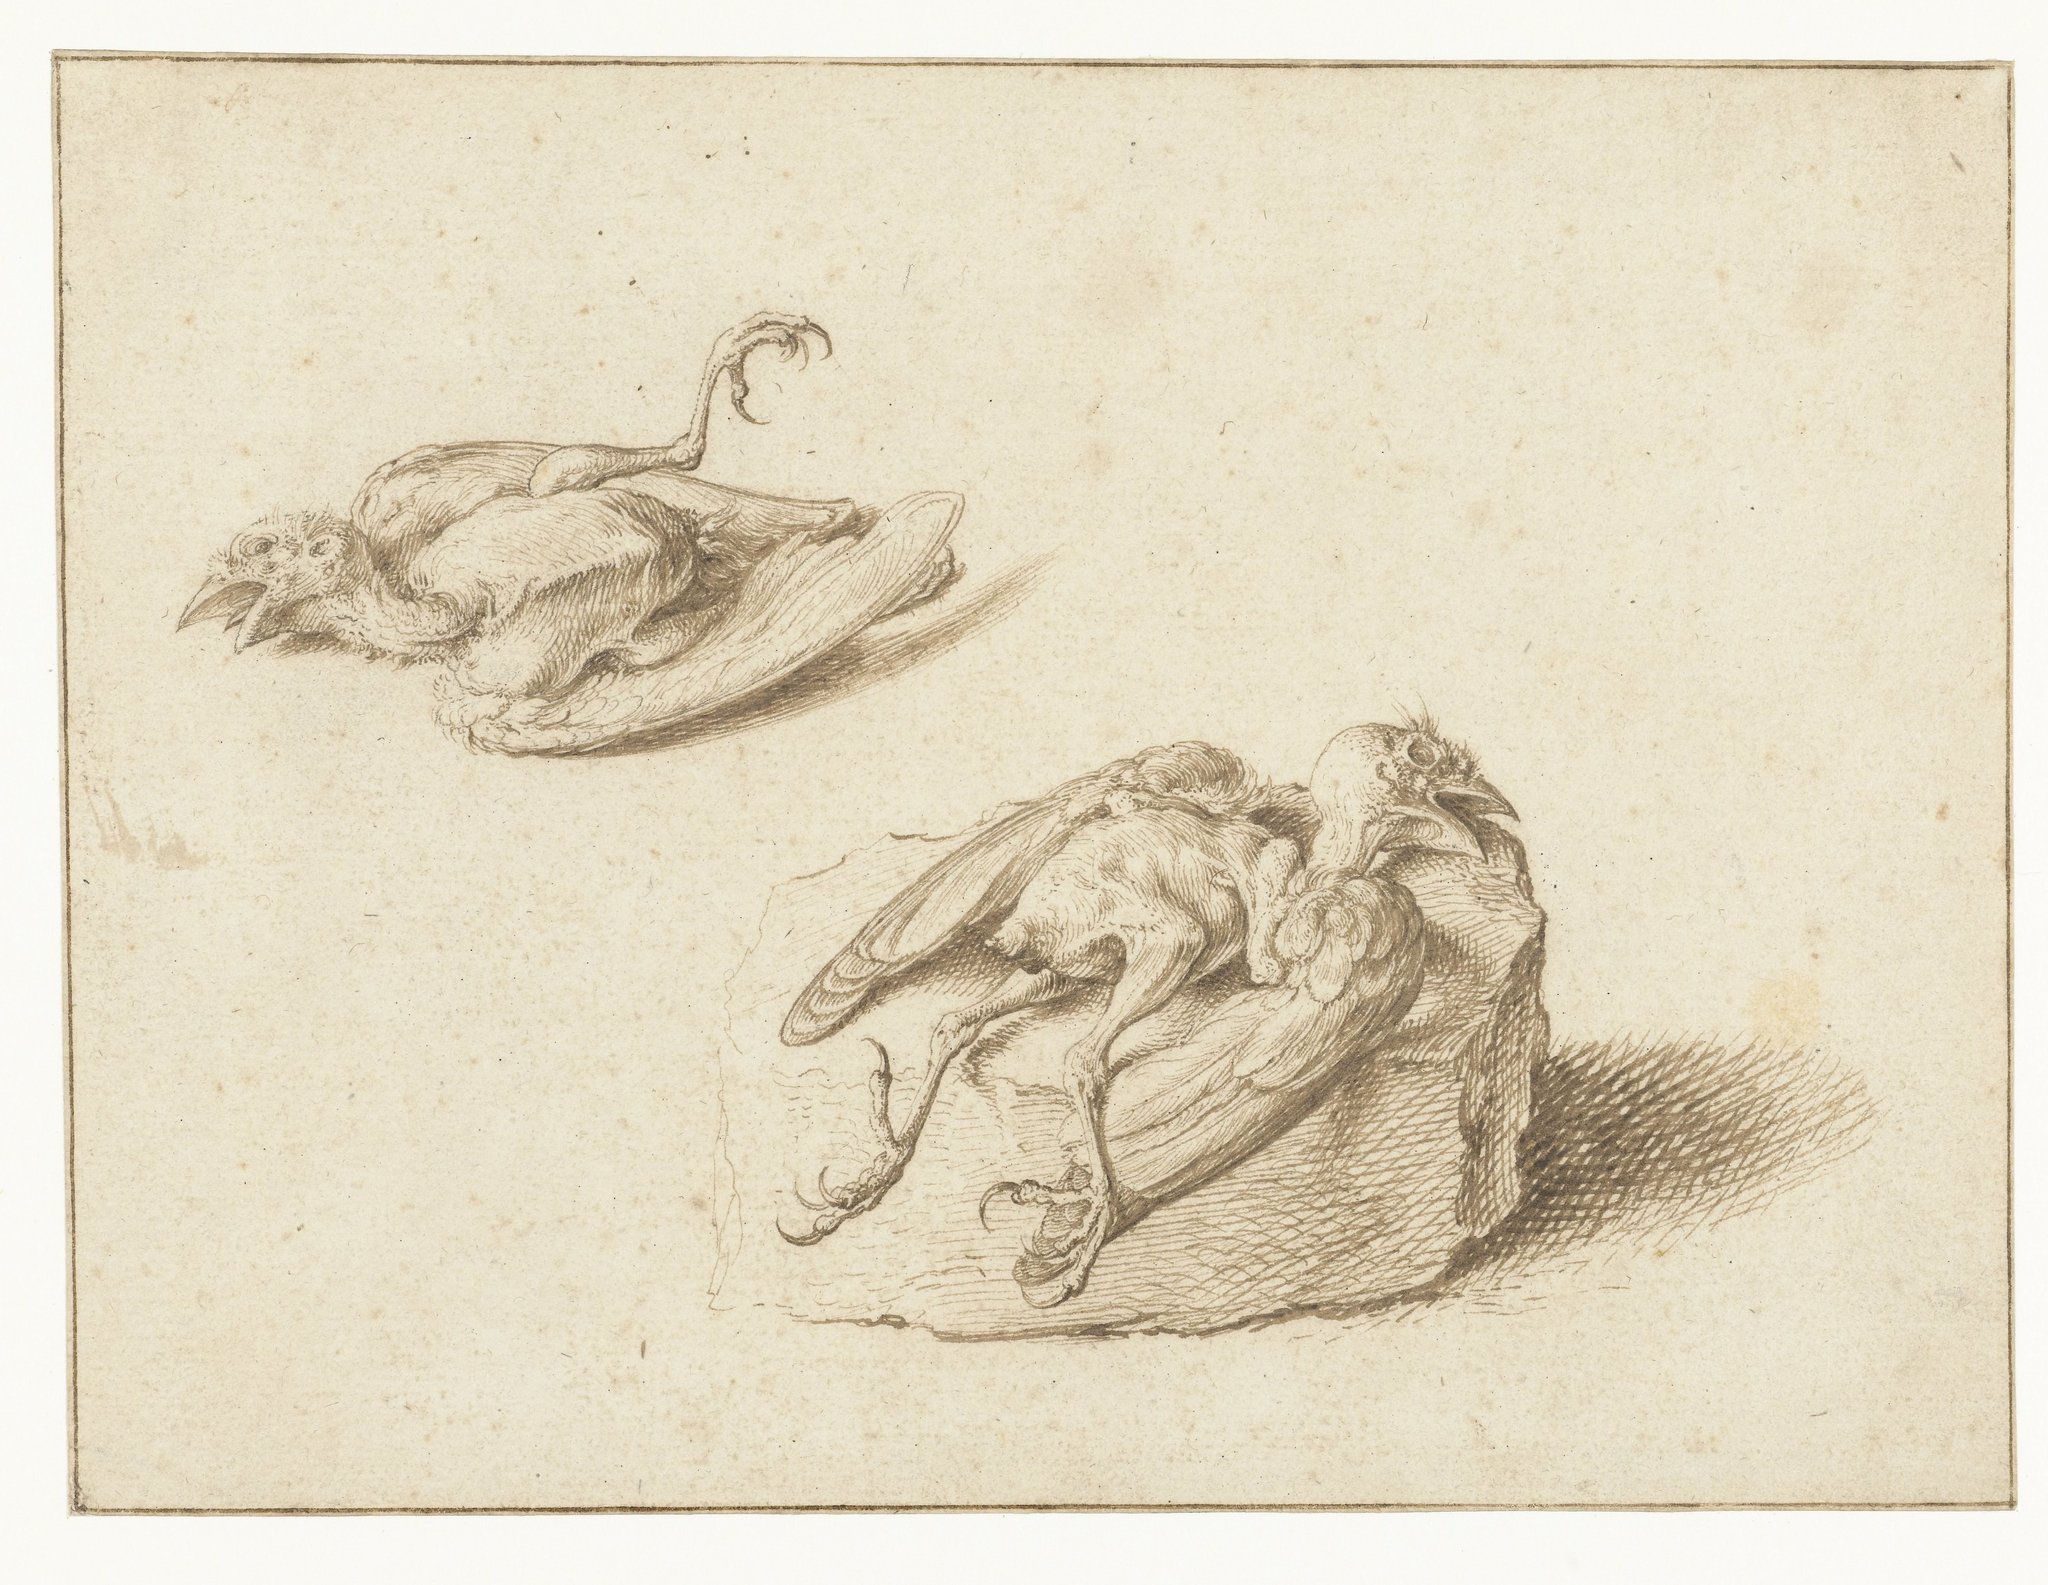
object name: drawing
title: Two Studies of a Dead Bird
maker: jacques de gheyn (ii)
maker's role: painter, print maker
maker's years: 1565-1629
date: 1575-1625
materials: ink, paper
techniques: pen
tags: birds (+ young animal), birds (+ dying animal; death of animal; dead animal)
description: At the close of the 16th century, artists became increasingly interested in nature. Jacob de Gheyn’s circle of friends included several scientists. His expertise and excellent observational skills enabled him to portray plants and animals with meticulous accuracy. Remarkably, he depicted this dead songbird, which seems to have only just crawled out of its egg, in two different ways, as a scientific researcher would have done.